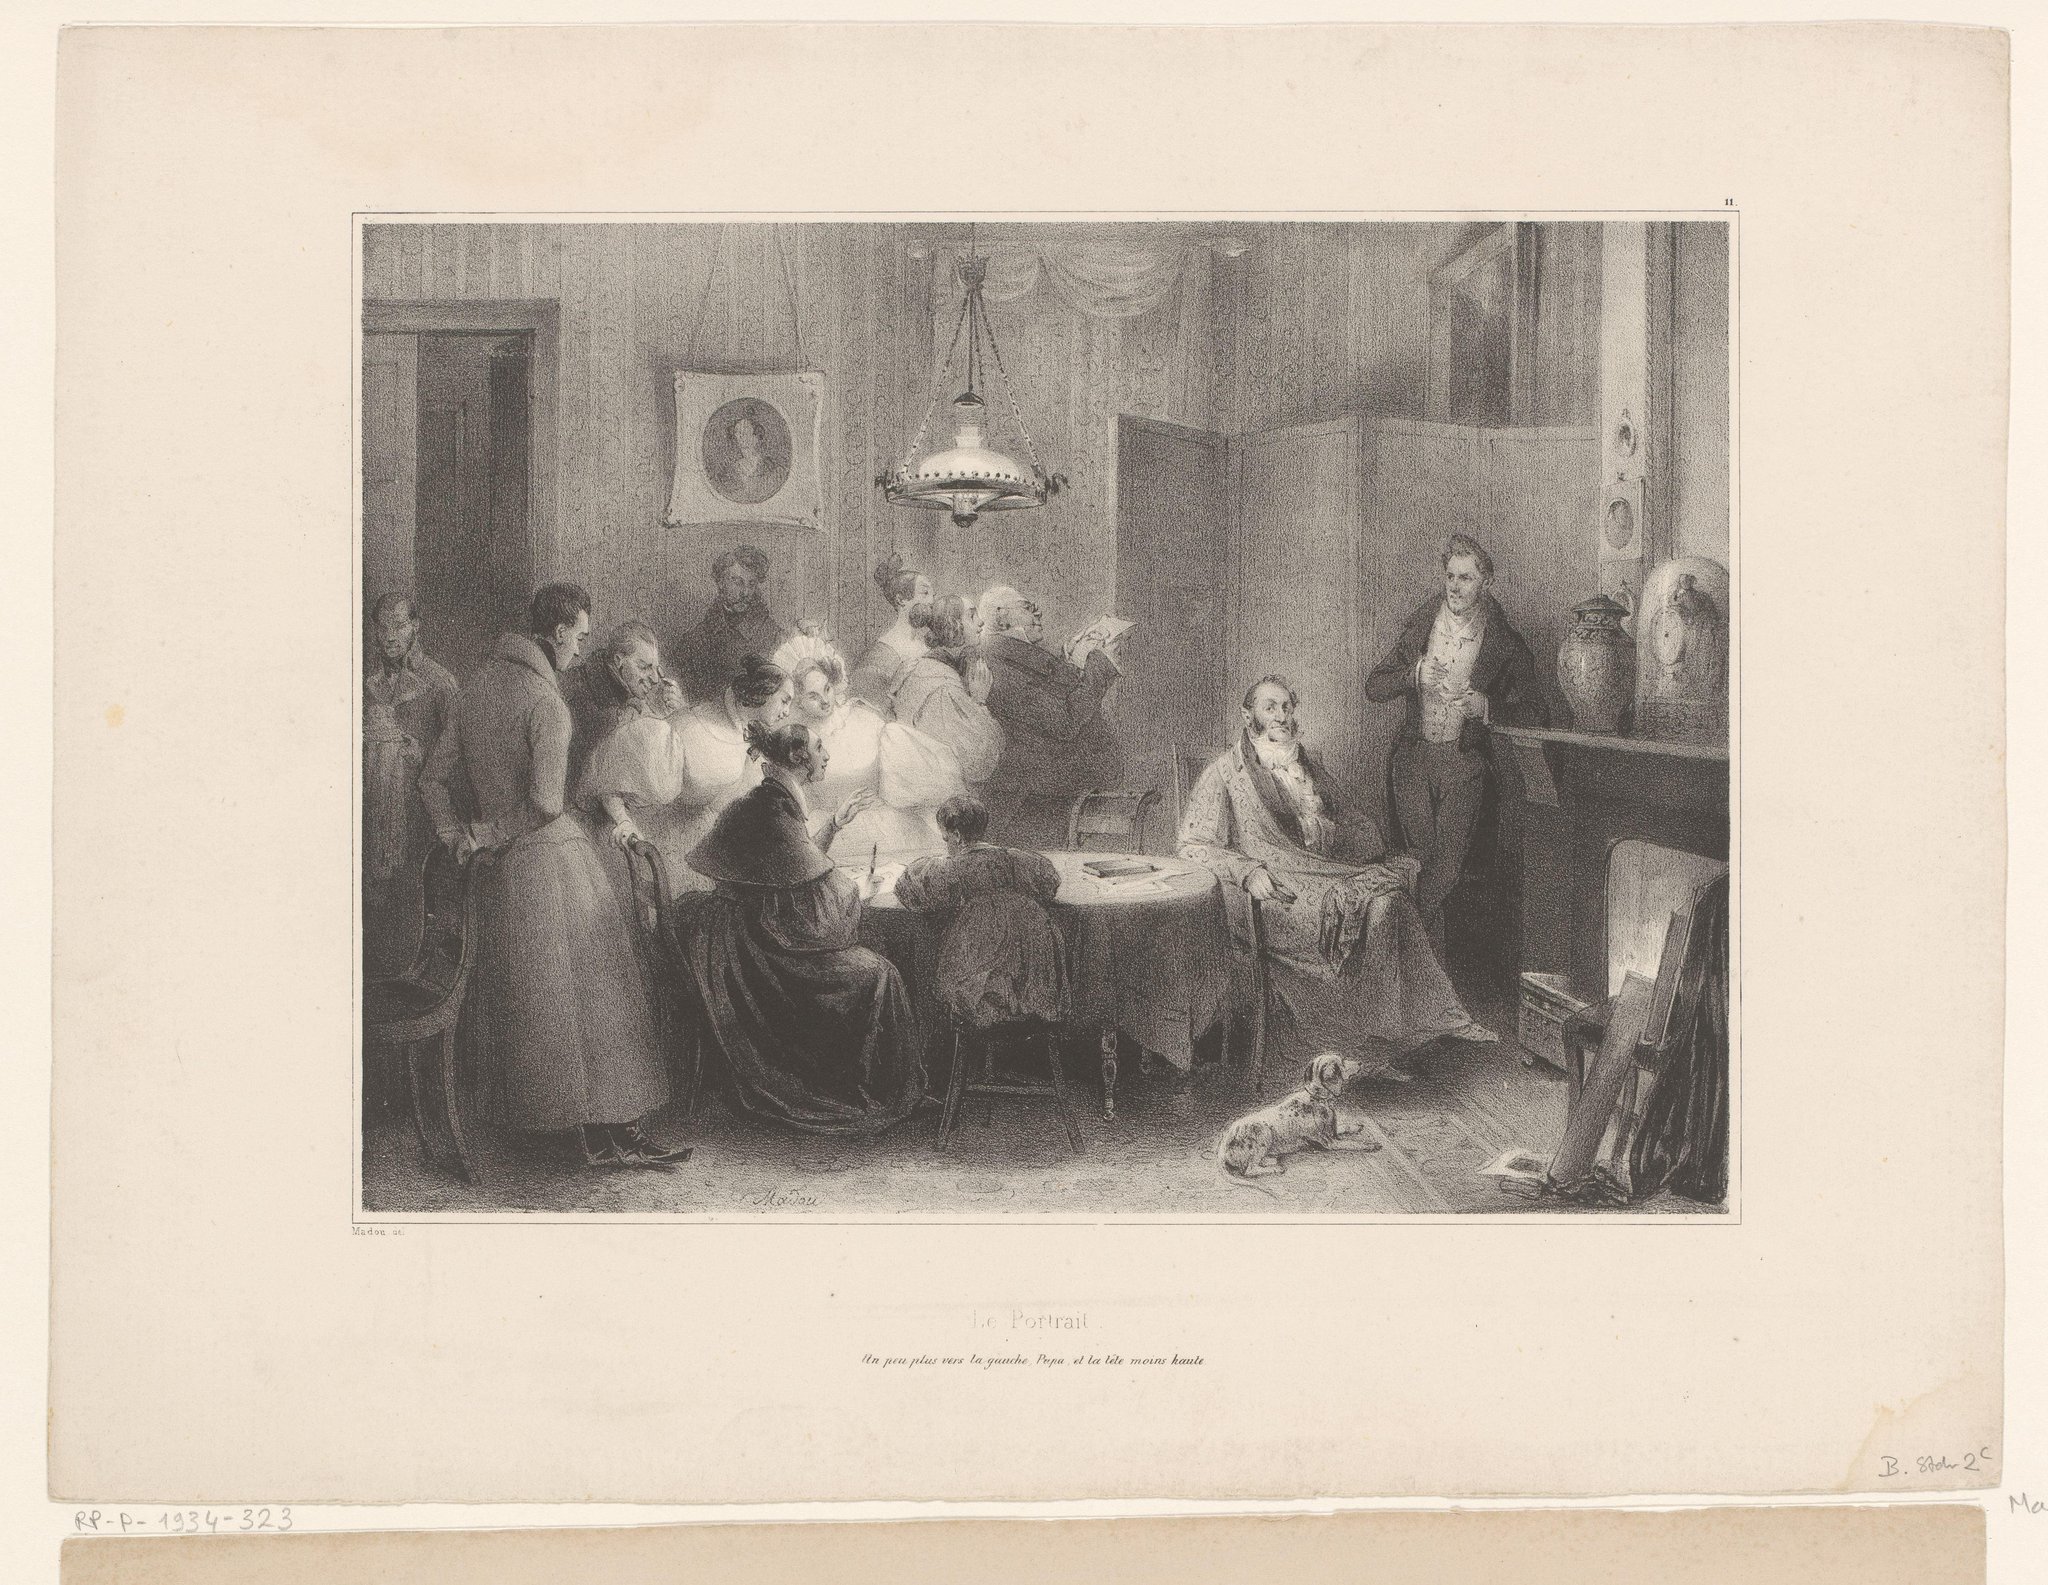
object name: print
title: Interieur met een groep mensen die een portret maakt van een man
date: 1806-1877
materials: paper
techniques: lithograph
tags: family life, anonymous historical person portrayed, interior of the house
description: Prent maakt deel uit van een serie met Belgische familietaferelen. Over deze serie is verder niets bekend. Het betreft voornamelijk huiselijke taferelen.